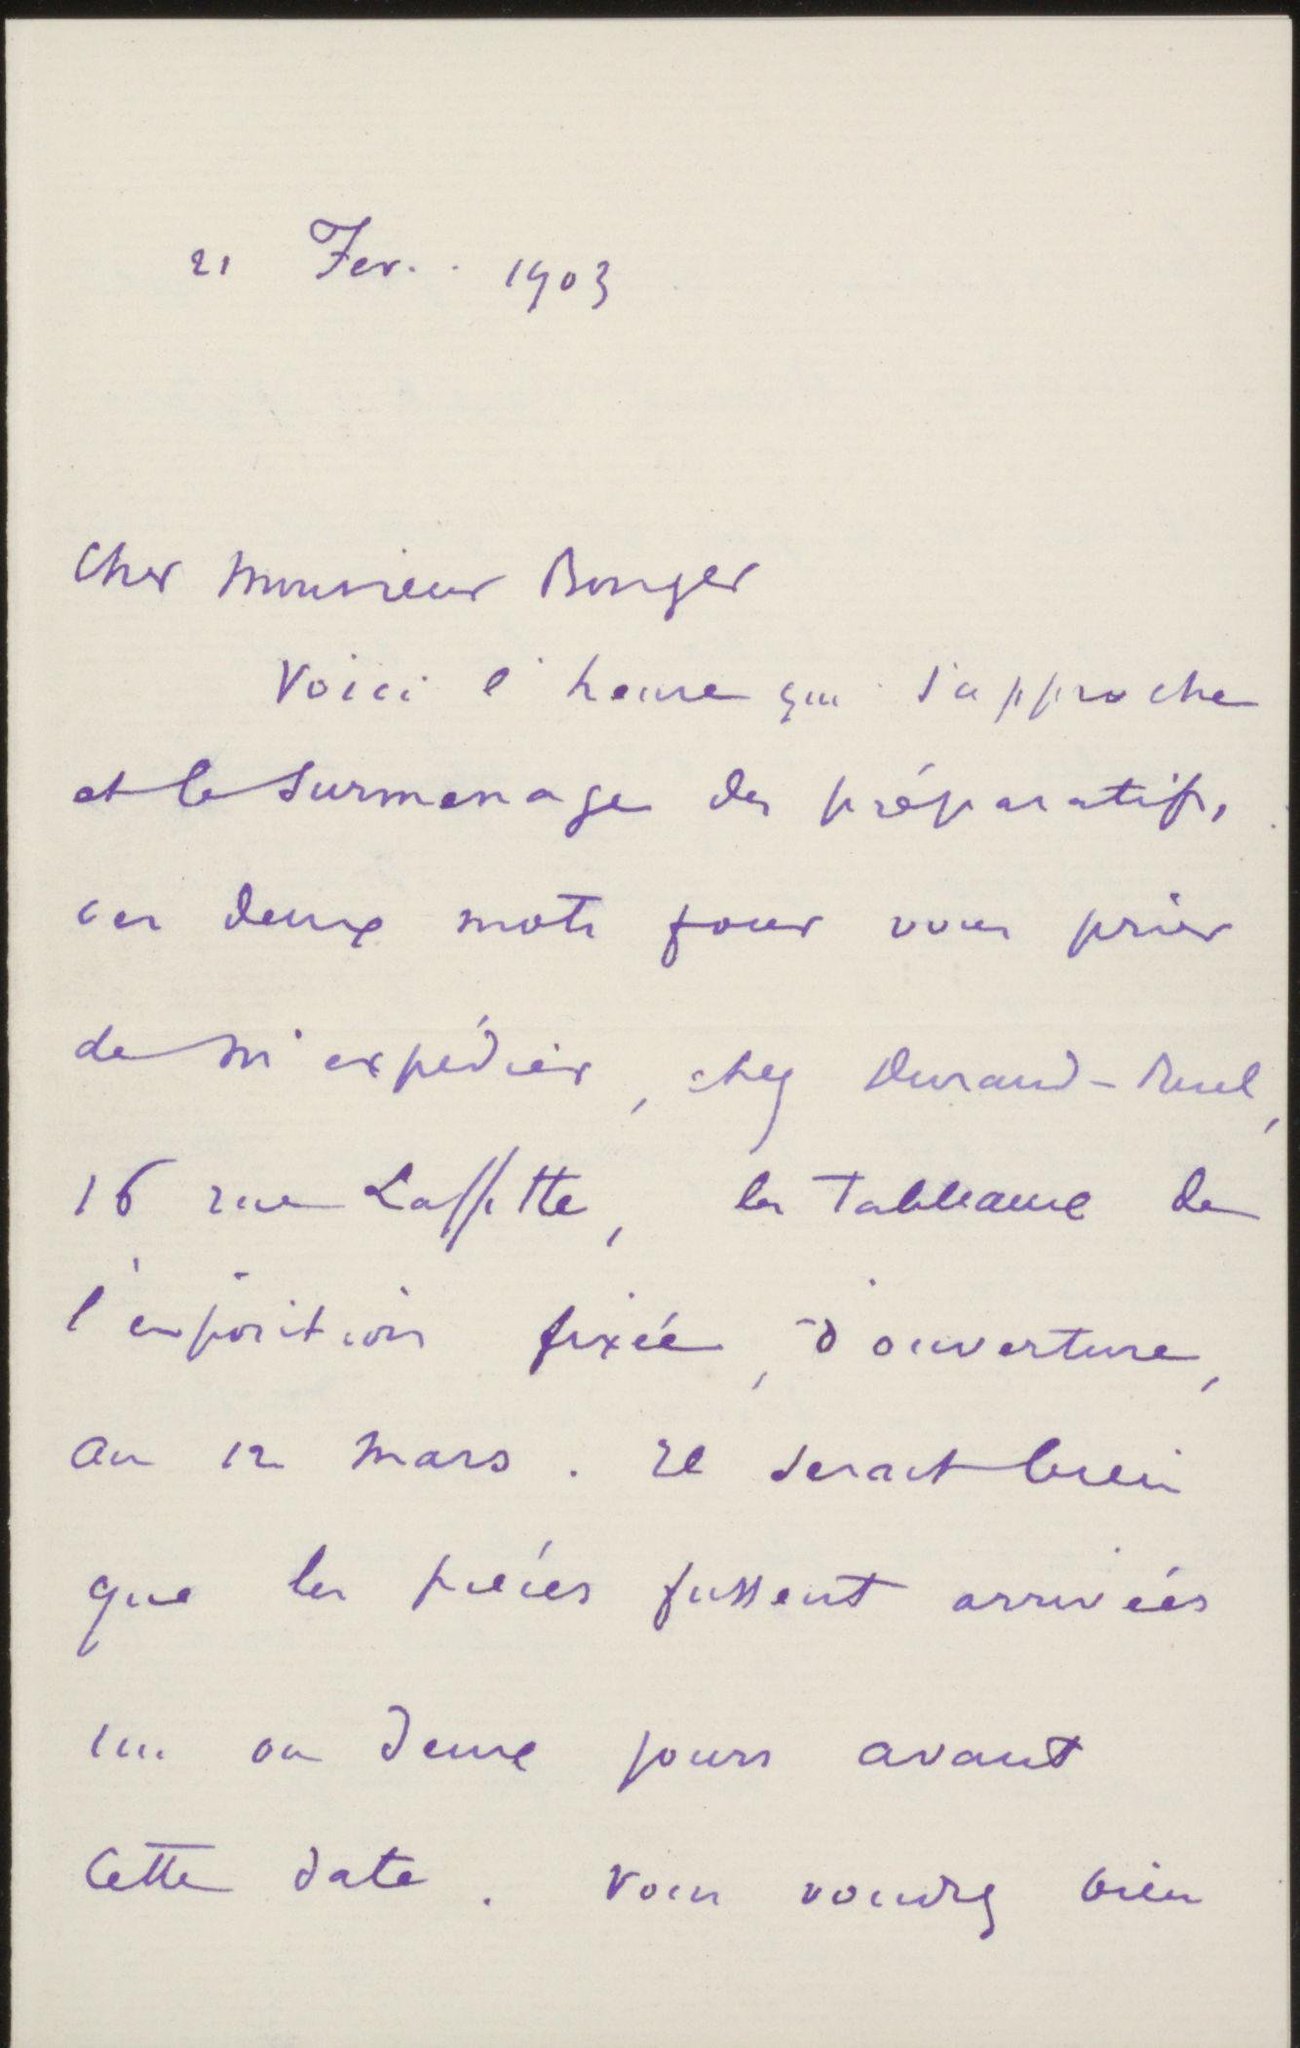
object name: letter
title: Brief aan Andries Bonger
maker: odilon redon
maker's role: draughtsman, painter, print maker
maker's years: 1840-1916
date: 1903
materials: ink, paper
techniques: pen, writing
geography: paris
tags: lille, print maker, émile bernard, amsterdam, andries bonger, marseille, gabriel mourey, drawing, painting (including book-illumination, miniature-painting), exhibition ~ art, printed matter, vienna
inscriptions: watermark